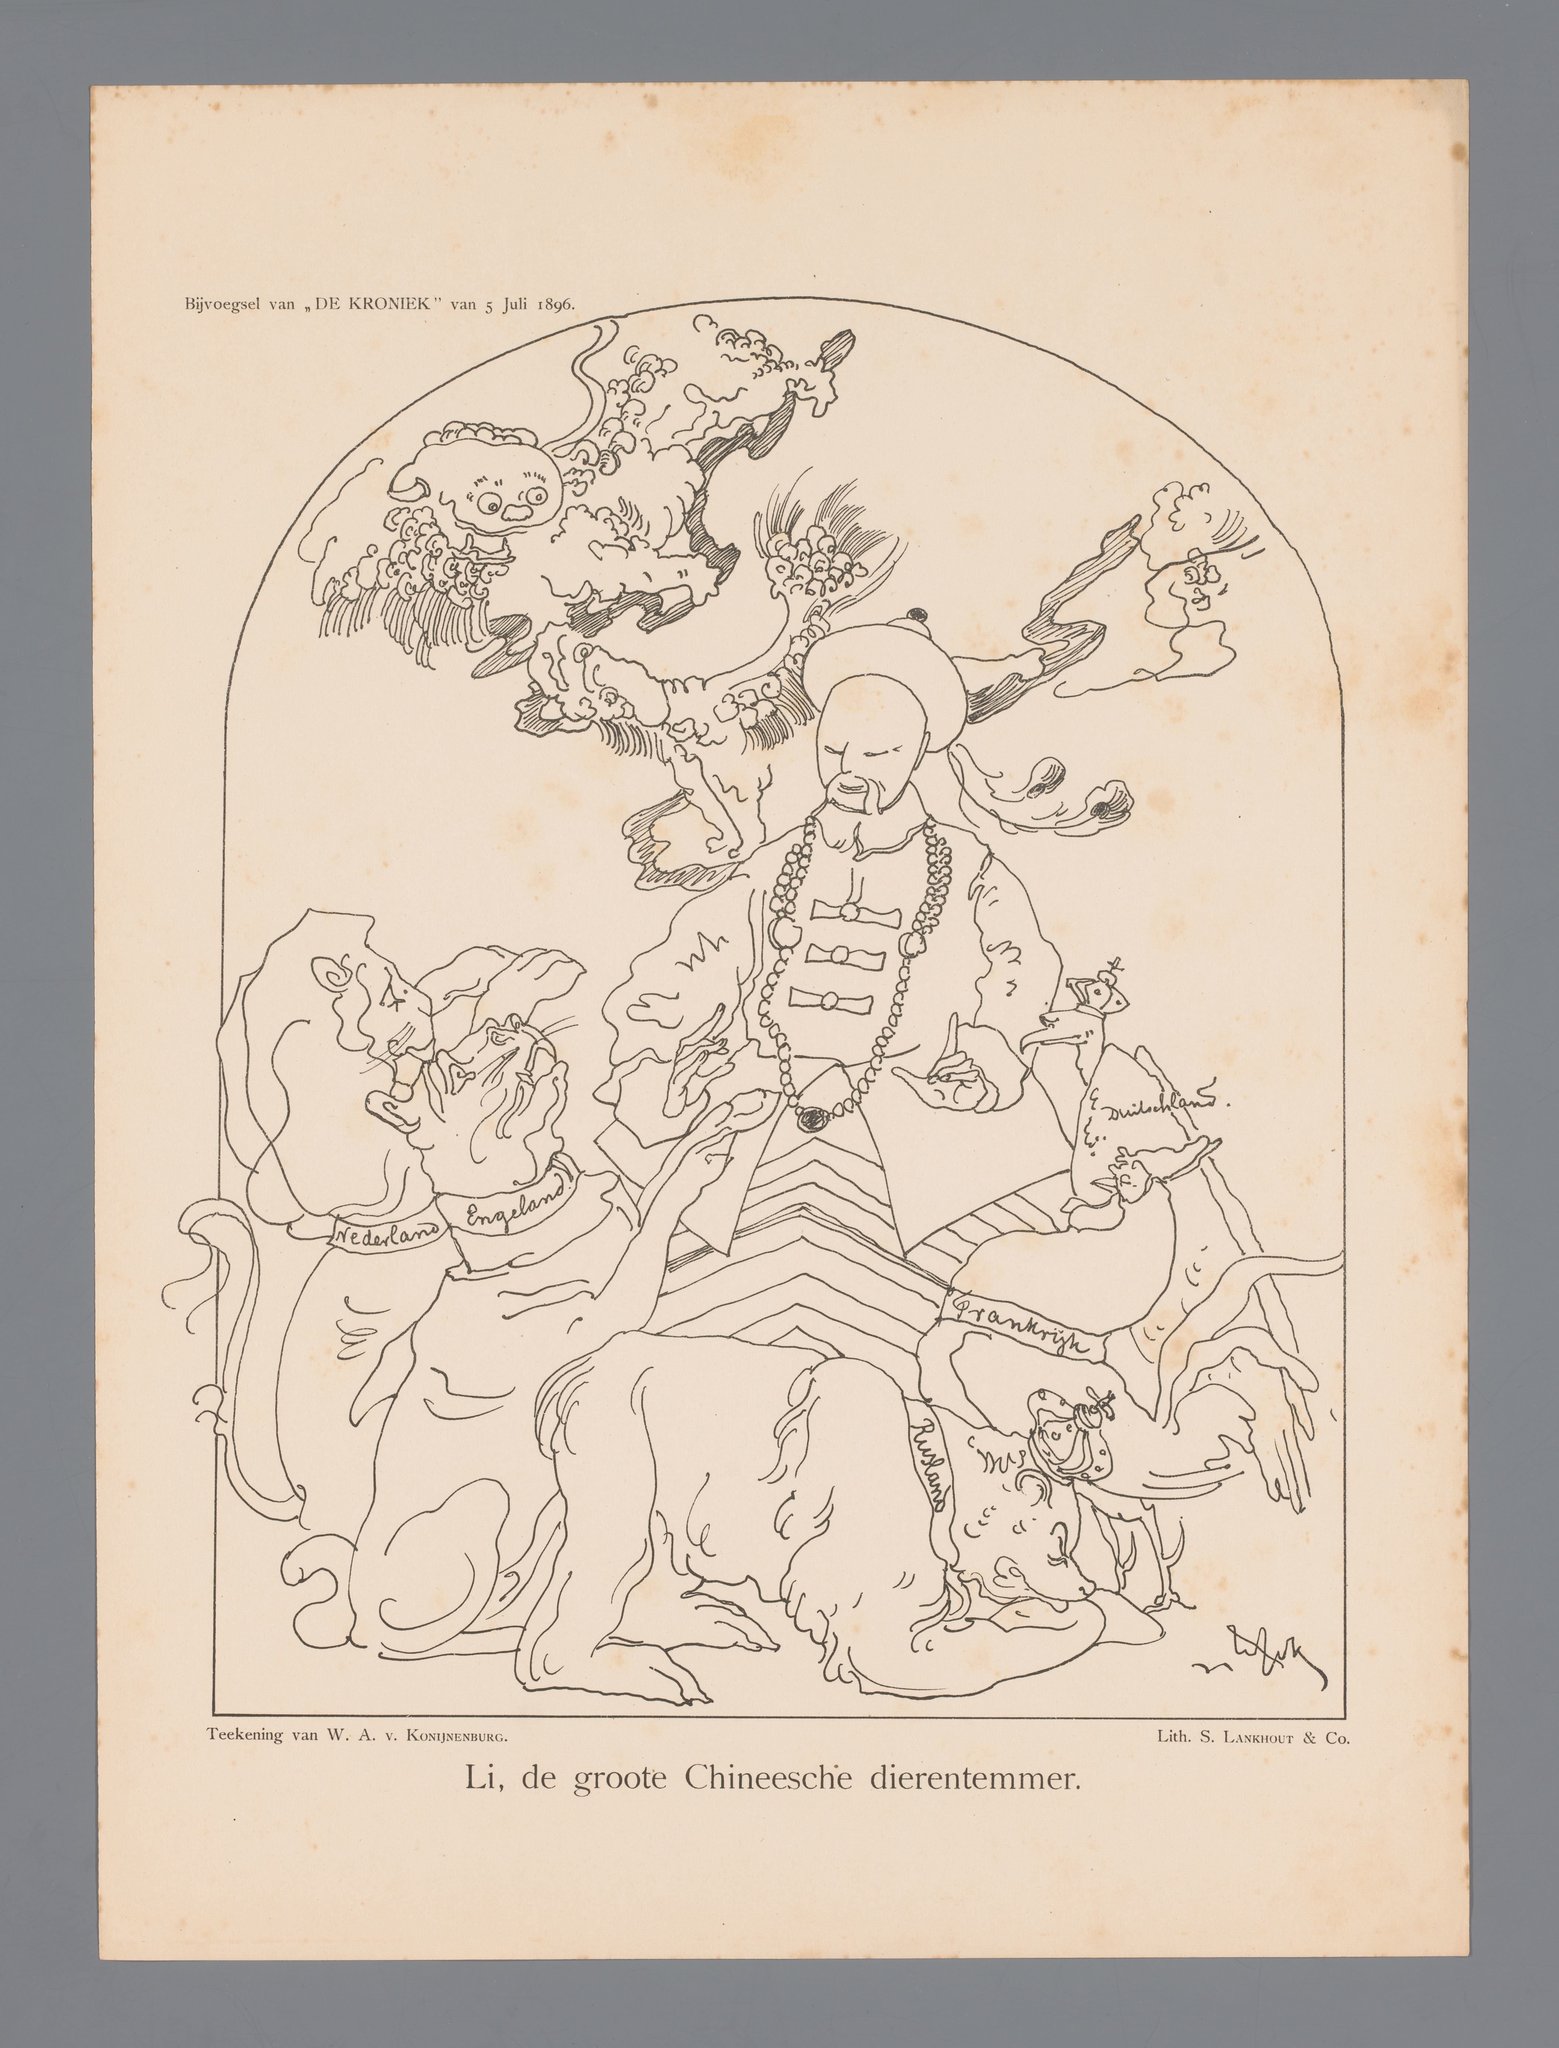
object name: print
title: Li, de groote Chineesche dierentemmer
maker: willem van konijnenburg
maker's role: draughtsman, painter, print maker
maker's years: 1868-1943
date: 1896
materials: paper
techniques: lithograph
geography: the hague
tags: chinese, personifications of countries, nations, states, districts, etc., taming, domestication of animals; tamed or domesticated animal, political caricatures and satires, china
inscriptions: date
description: Prent uit het bijvoegsel van: De Kroniek 2 (1896), 5 juli 1896.